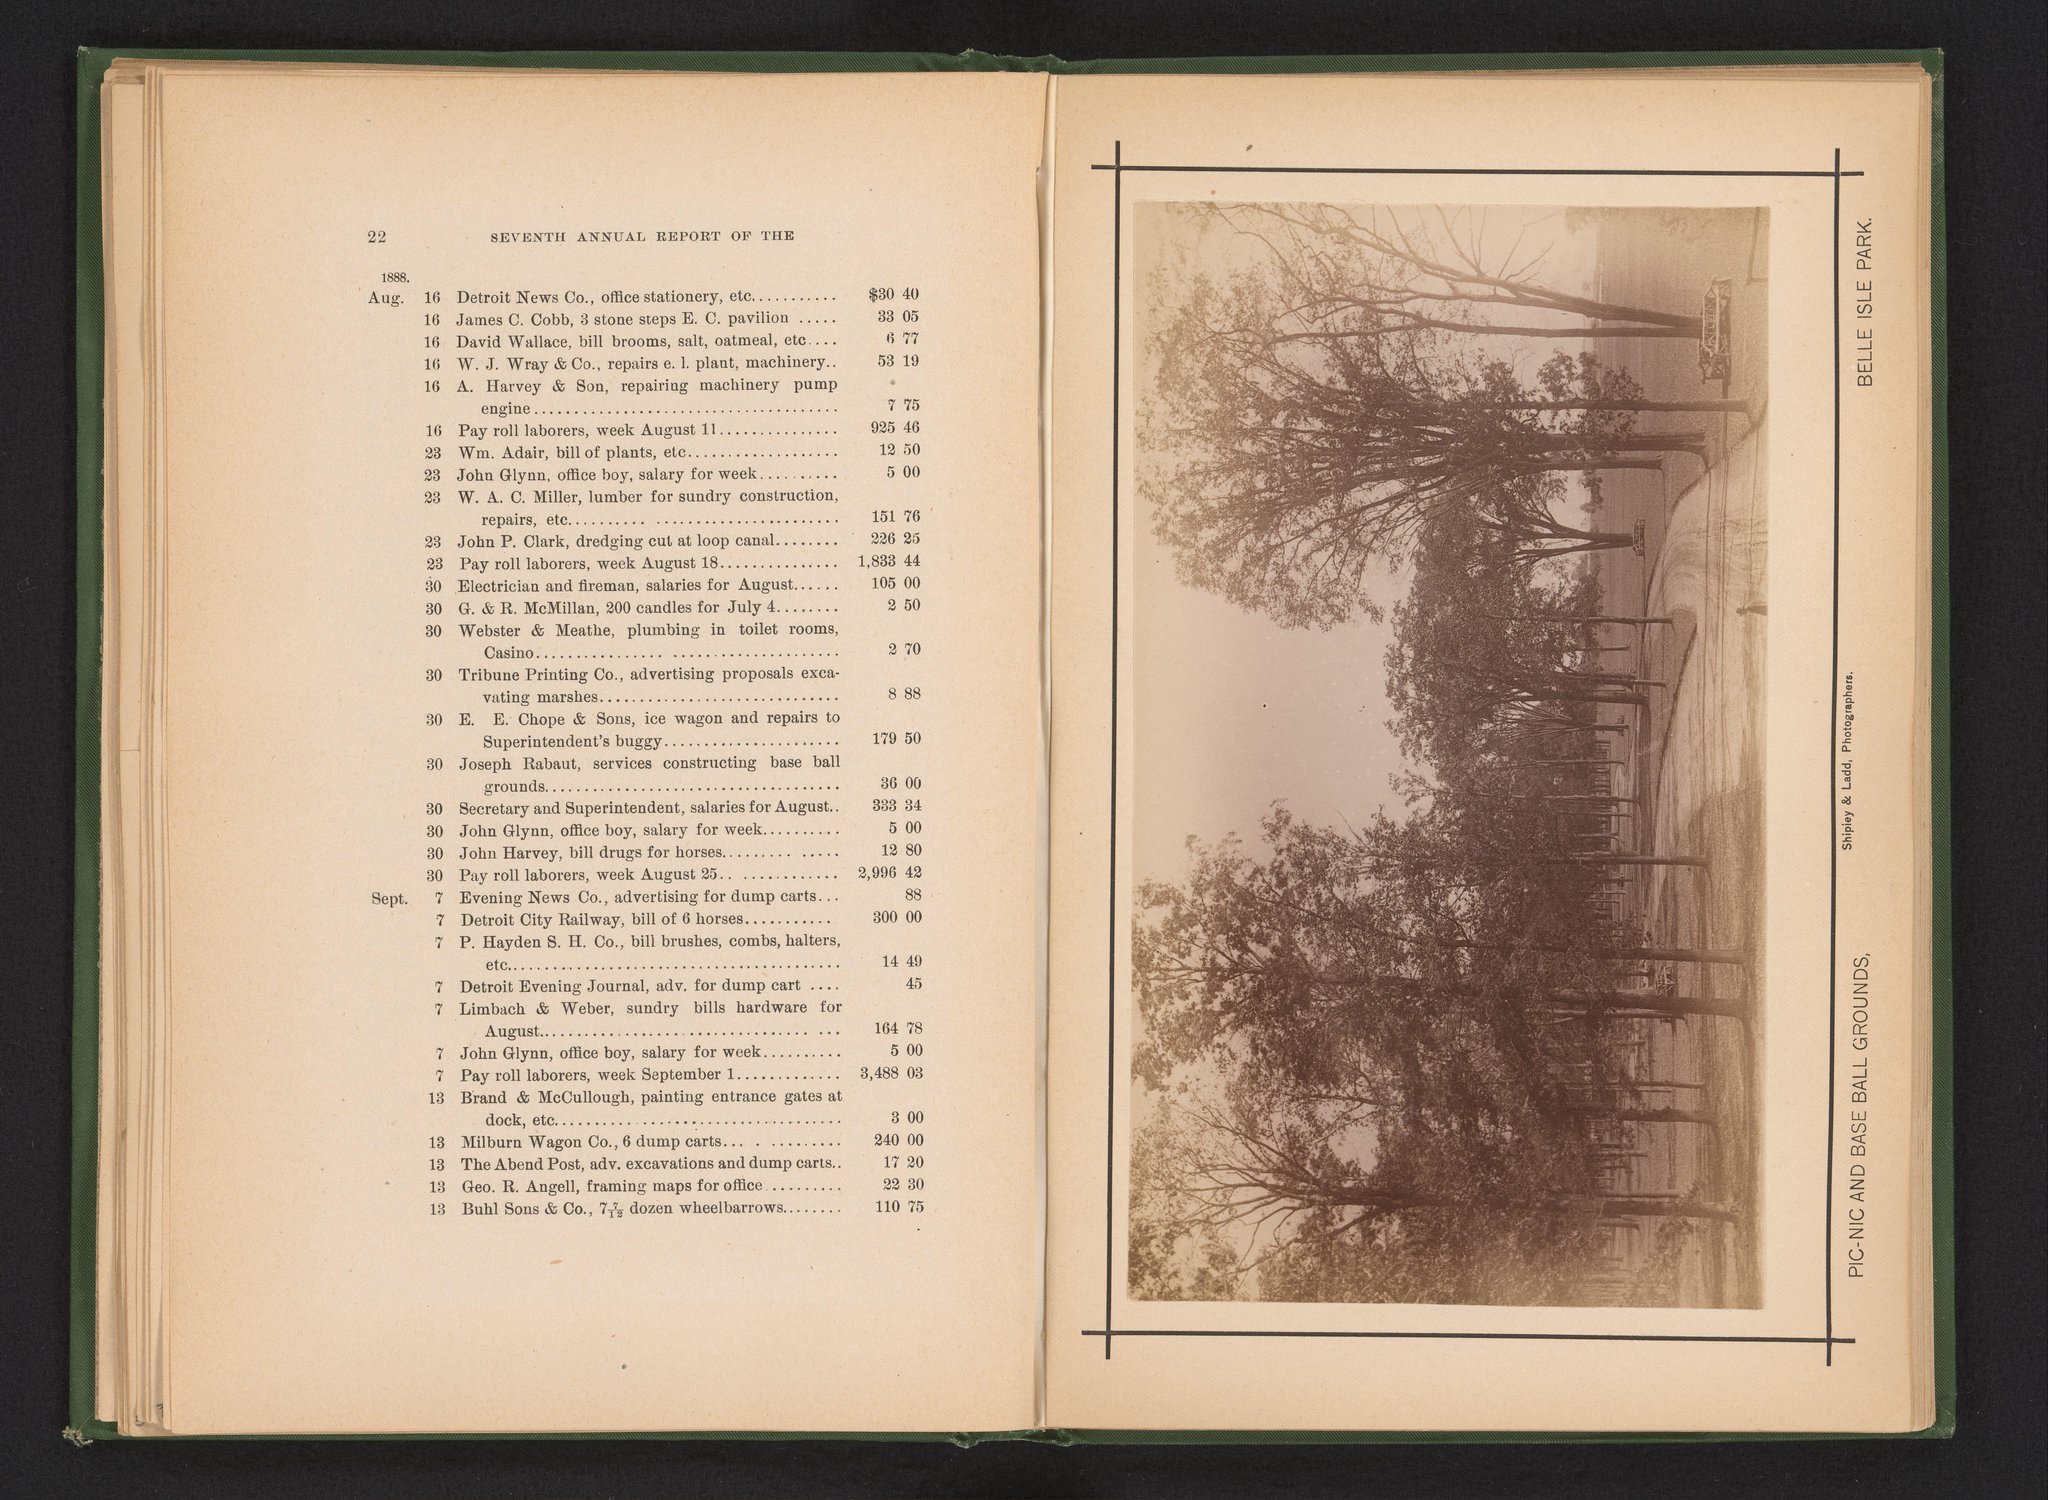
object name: photograph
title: Pic-nic and base ball grounds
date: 1879-1889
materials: photographic support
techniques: albumen print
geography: belle isle park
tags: public gardens, park